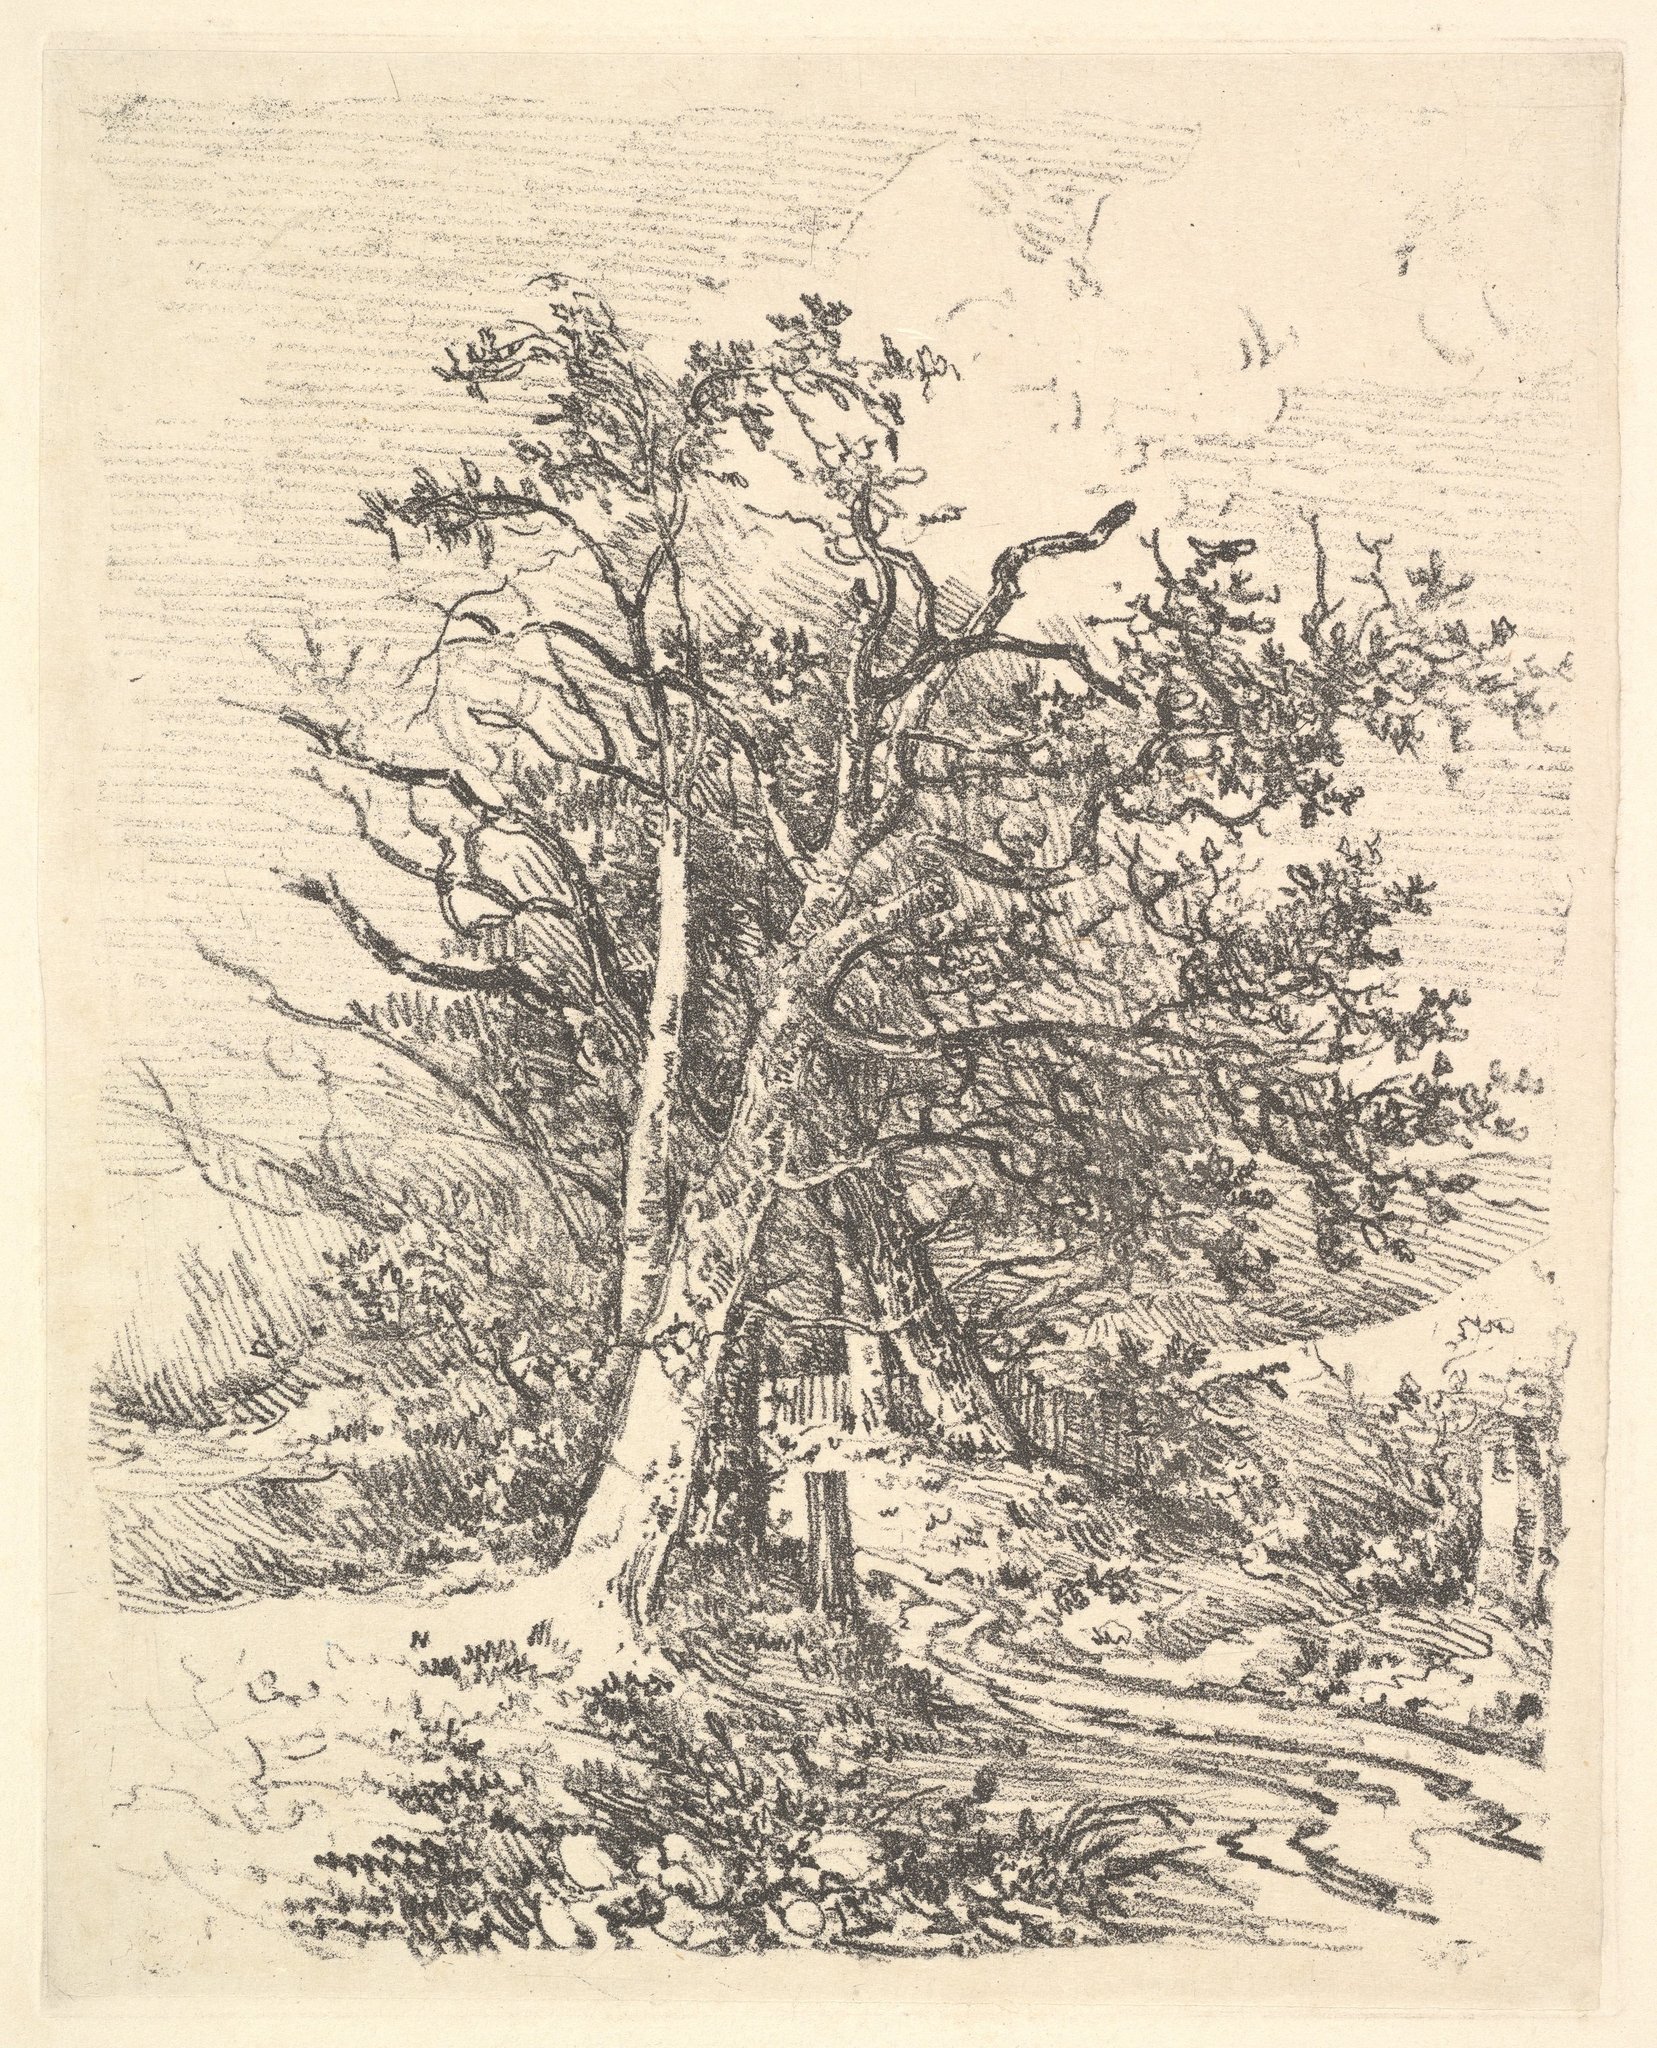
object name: print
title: Tree Trunks and Lane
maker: john crome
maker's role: artist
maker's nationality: british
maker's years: 1768-1821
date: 1811-1813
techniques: printmaking, etching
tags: trees